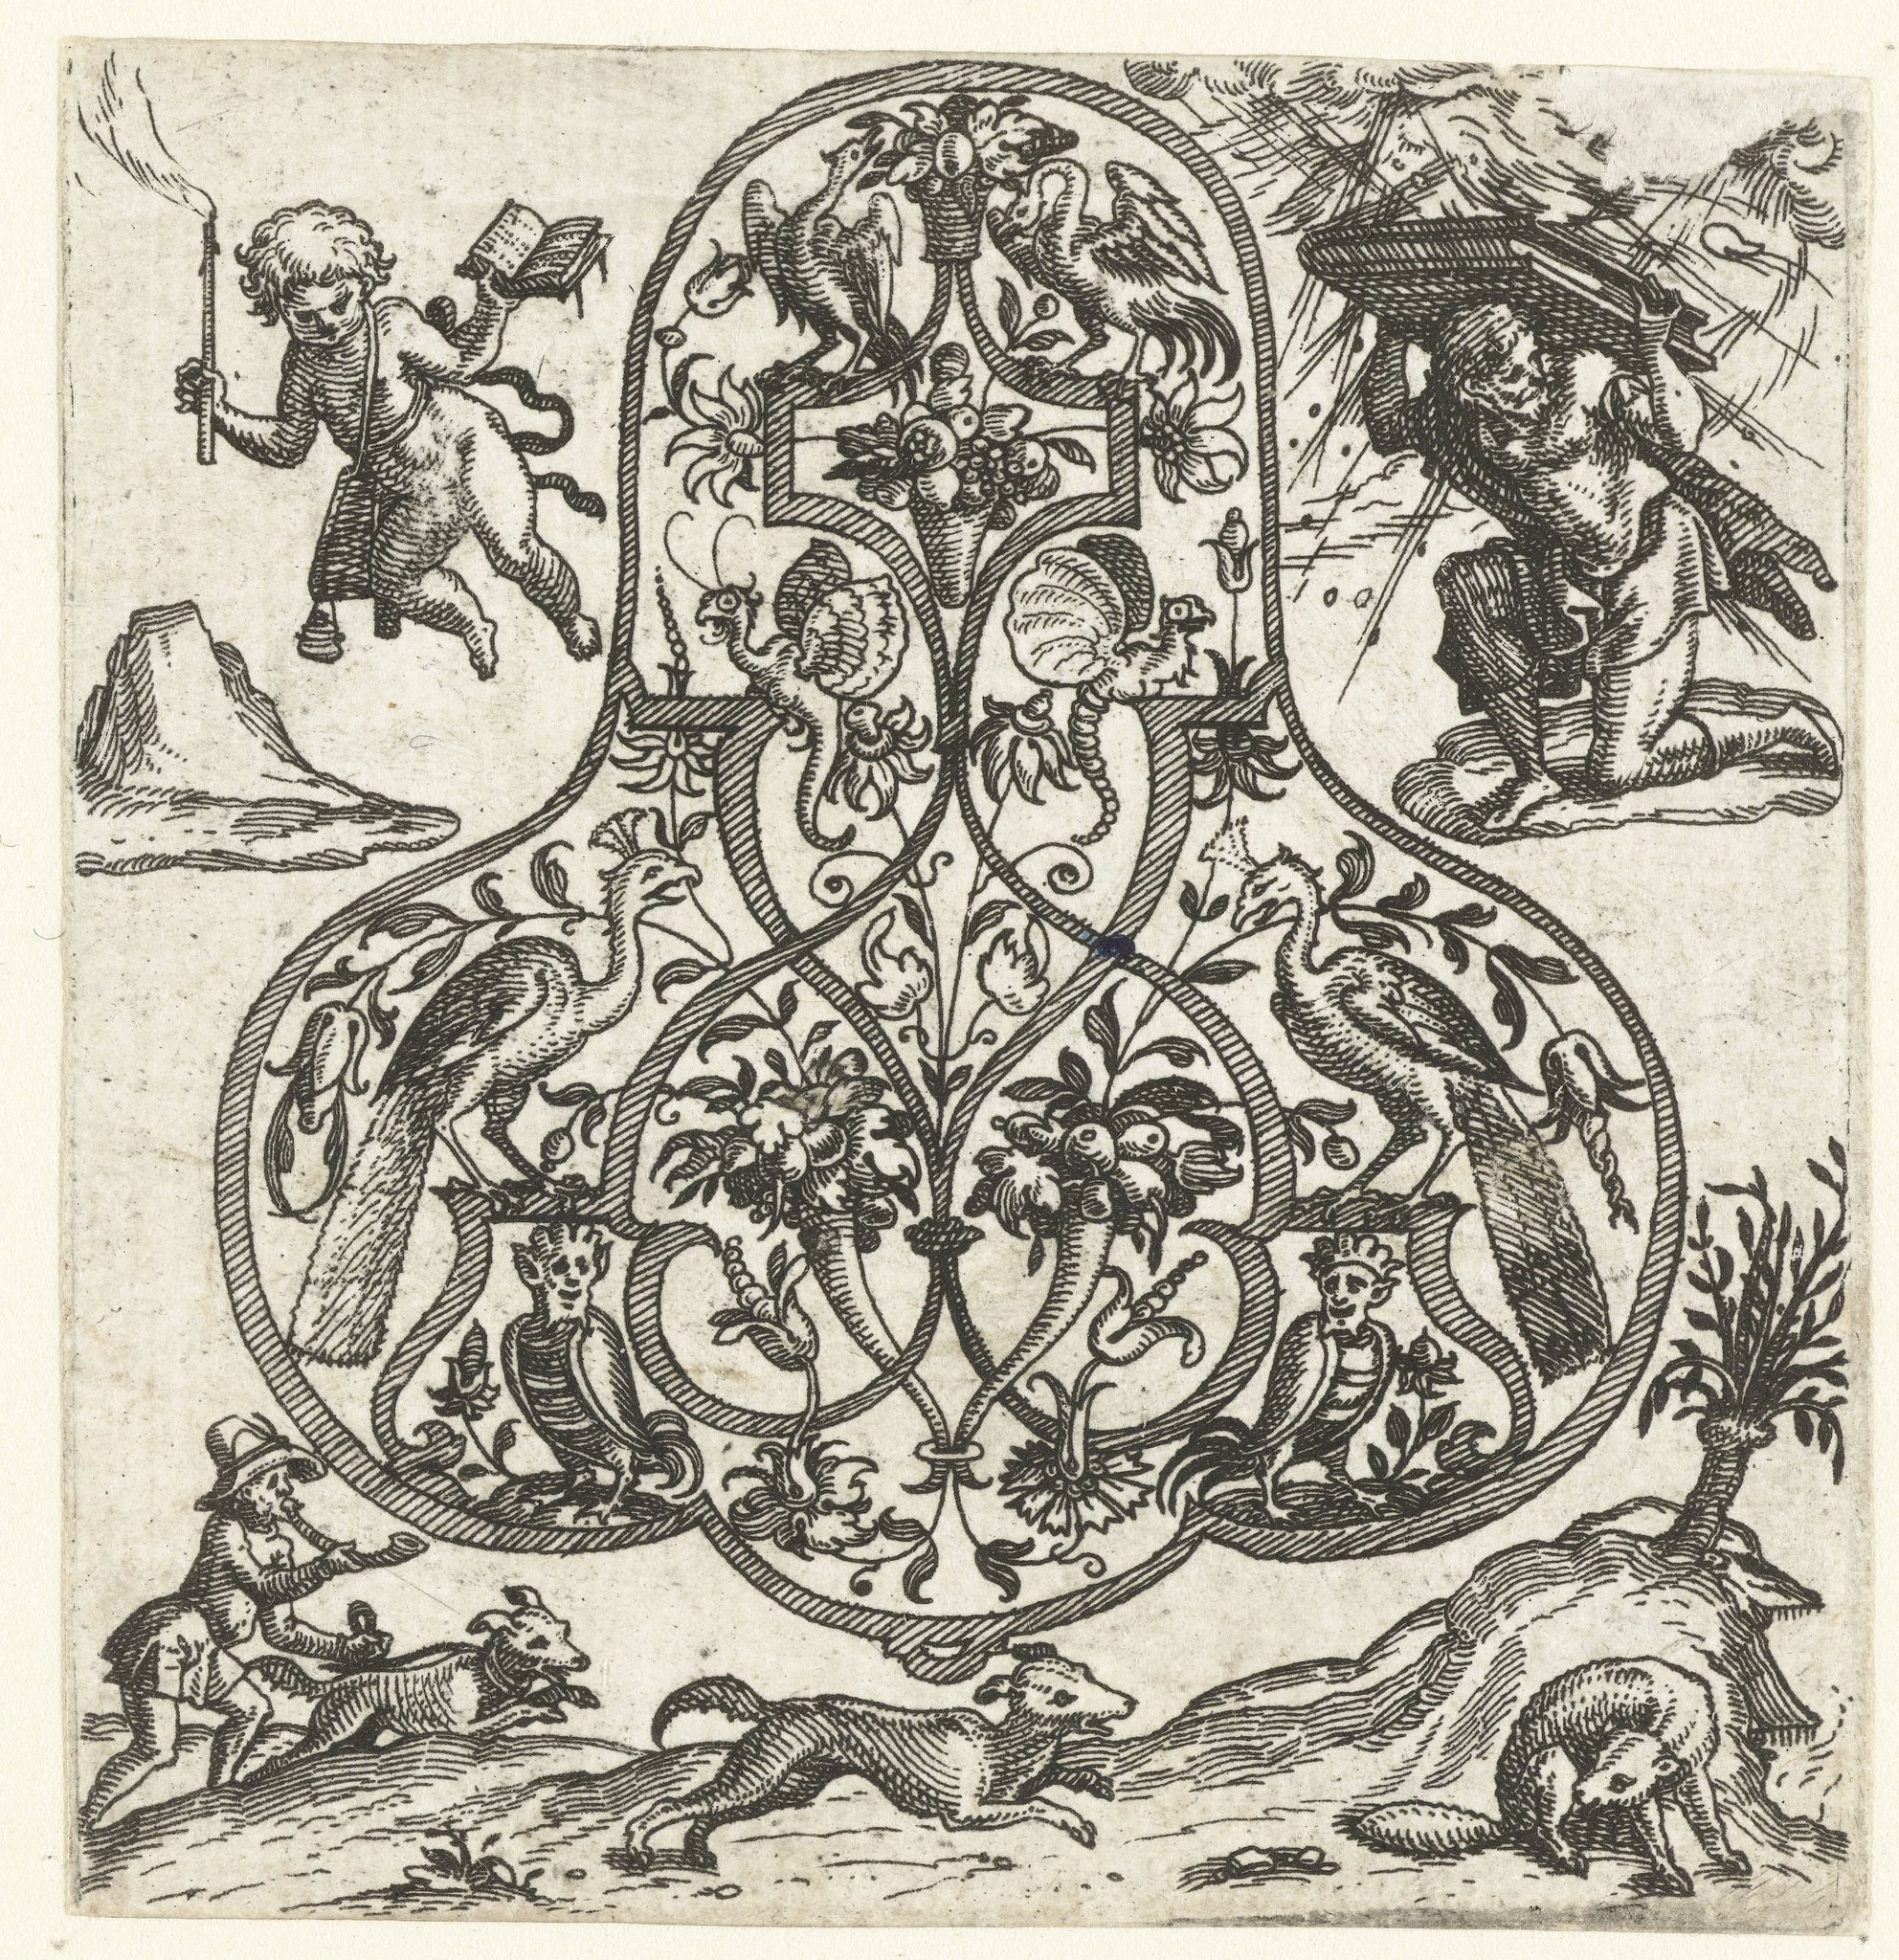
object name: print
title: Peervormige hangers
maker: dietrich meyer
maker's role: painter, print maker, publisher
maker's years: 1572-1658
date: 1600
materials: paper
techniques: etching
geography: zurich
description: Linksboven een vliegende putto met een kaars en een boek, rechtsboven probeert een man zichzelf met een boek te beschermen tegen een hagelstorm (Moses?). Onderaan een jachtscène. Een van 8 ongenummerde bladen uit een serie van 12.